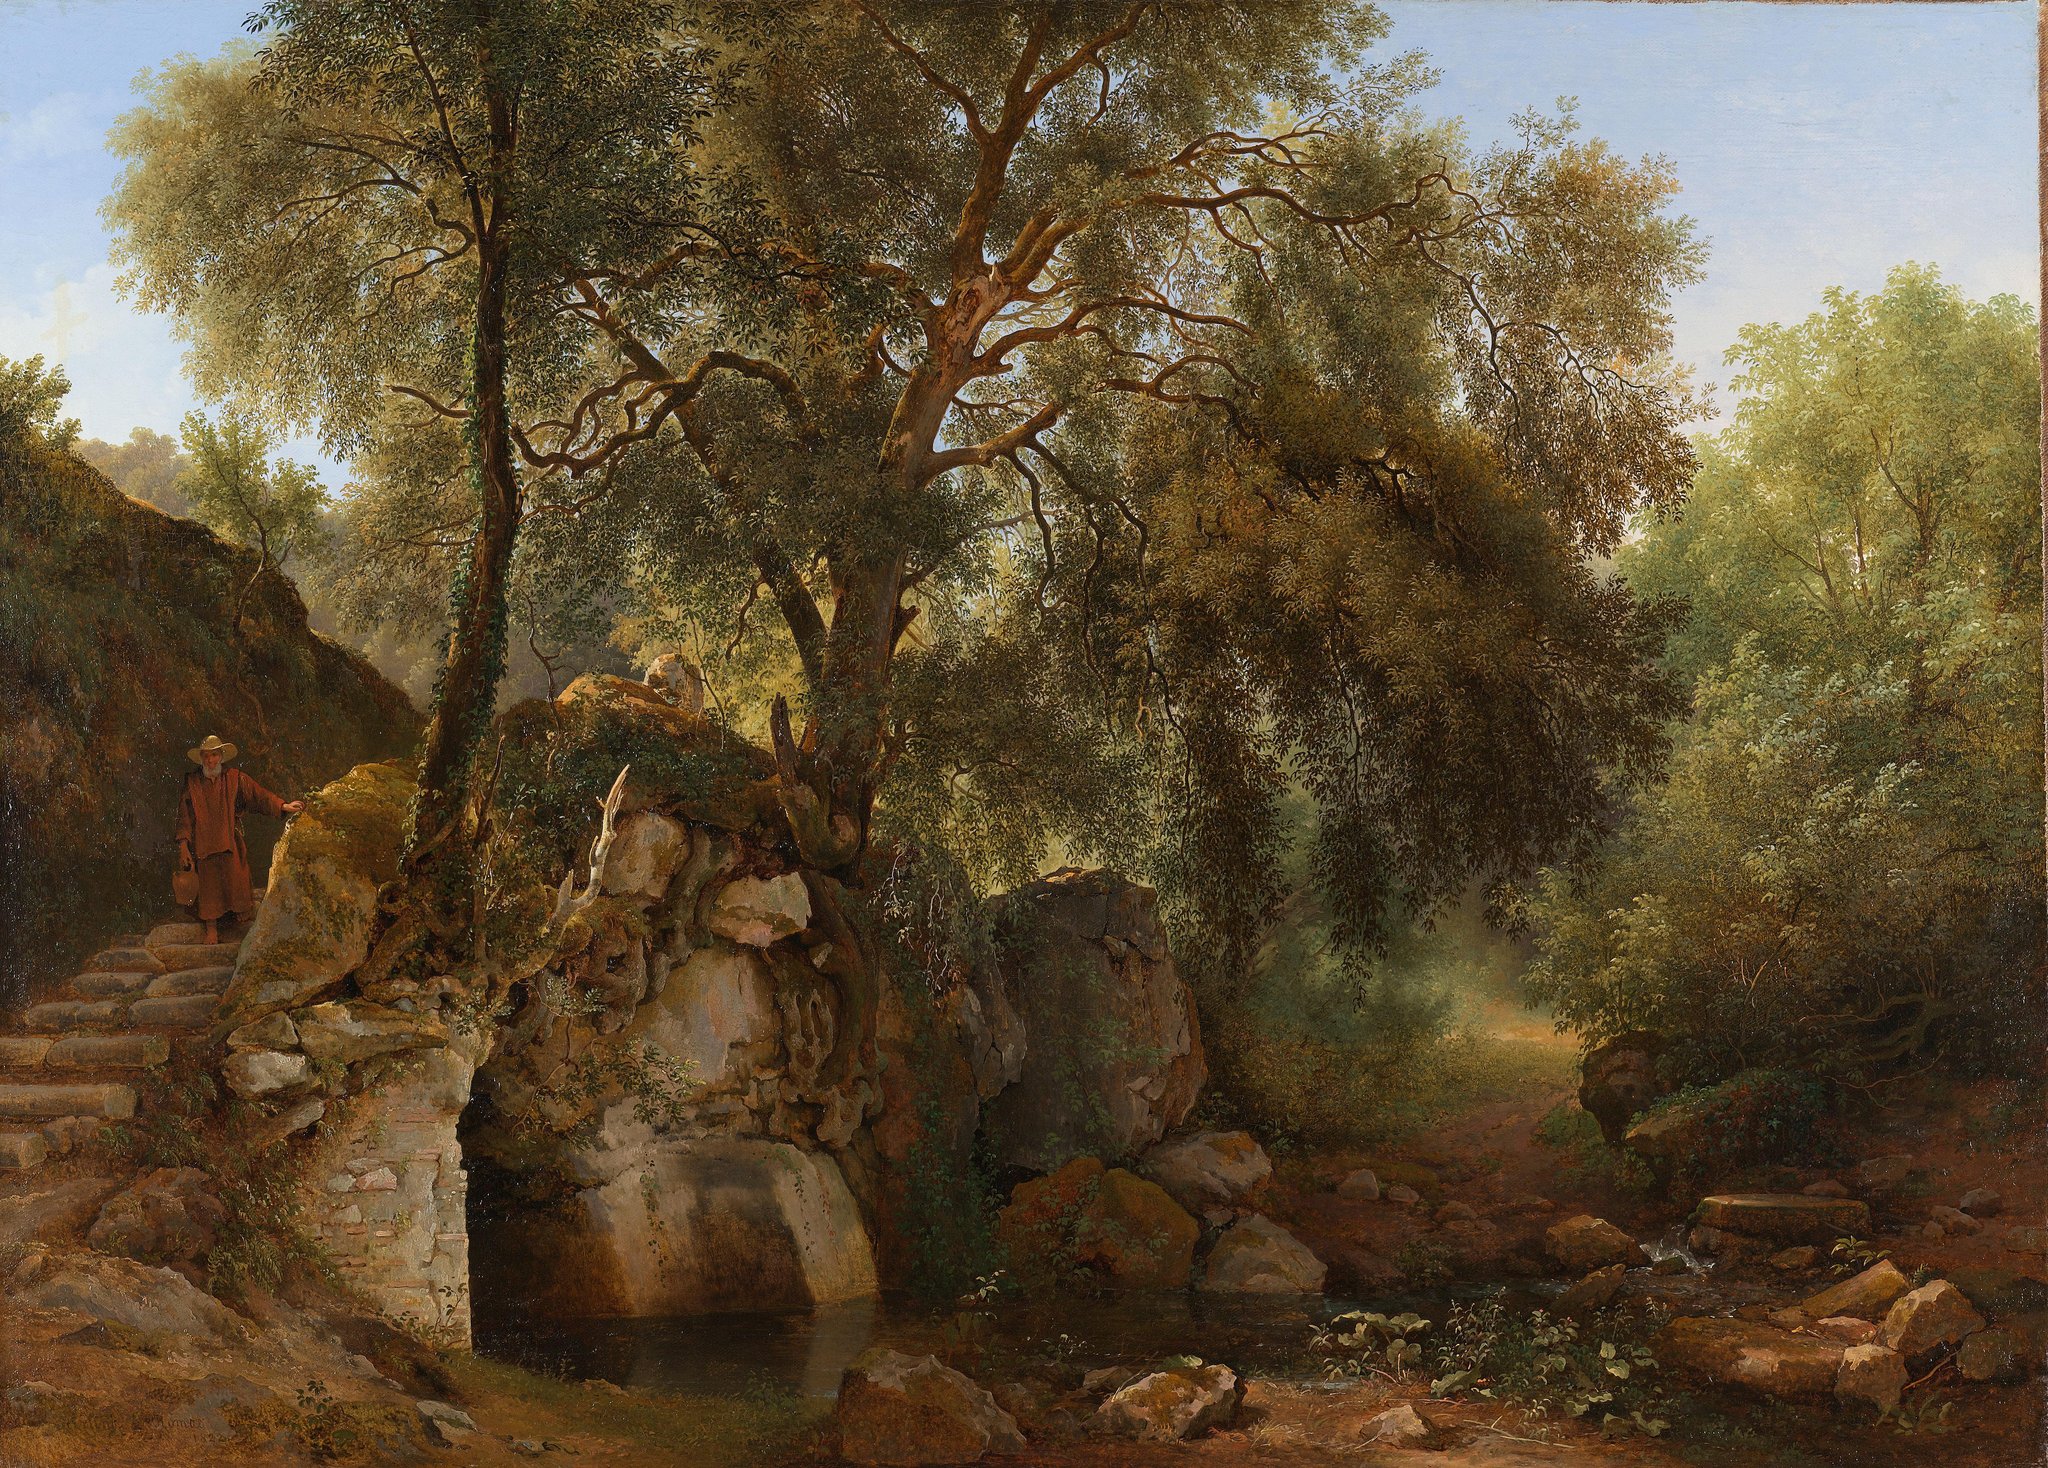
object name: painting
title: View in the Park of the Villa Chigi at Ariccia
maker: abraham teerlink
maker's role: draughtsman, painter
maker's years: 1776-1857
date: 1822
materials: canvas, oil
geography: rome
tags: trees, rocks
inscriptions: signature and date: ‘Teerlink. Romae/ 1822.’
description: Teerlink mainly painted sweeping, panoramic views. In this painting, however, he depicted a small slice of nature in a large format. The monk descending to fetch water leads the viewer’s eye to the flowing stream in the foreground. The painter probably relied on his portfolio of sketches from nature for the many details in this scene, such as the plants by the stream.